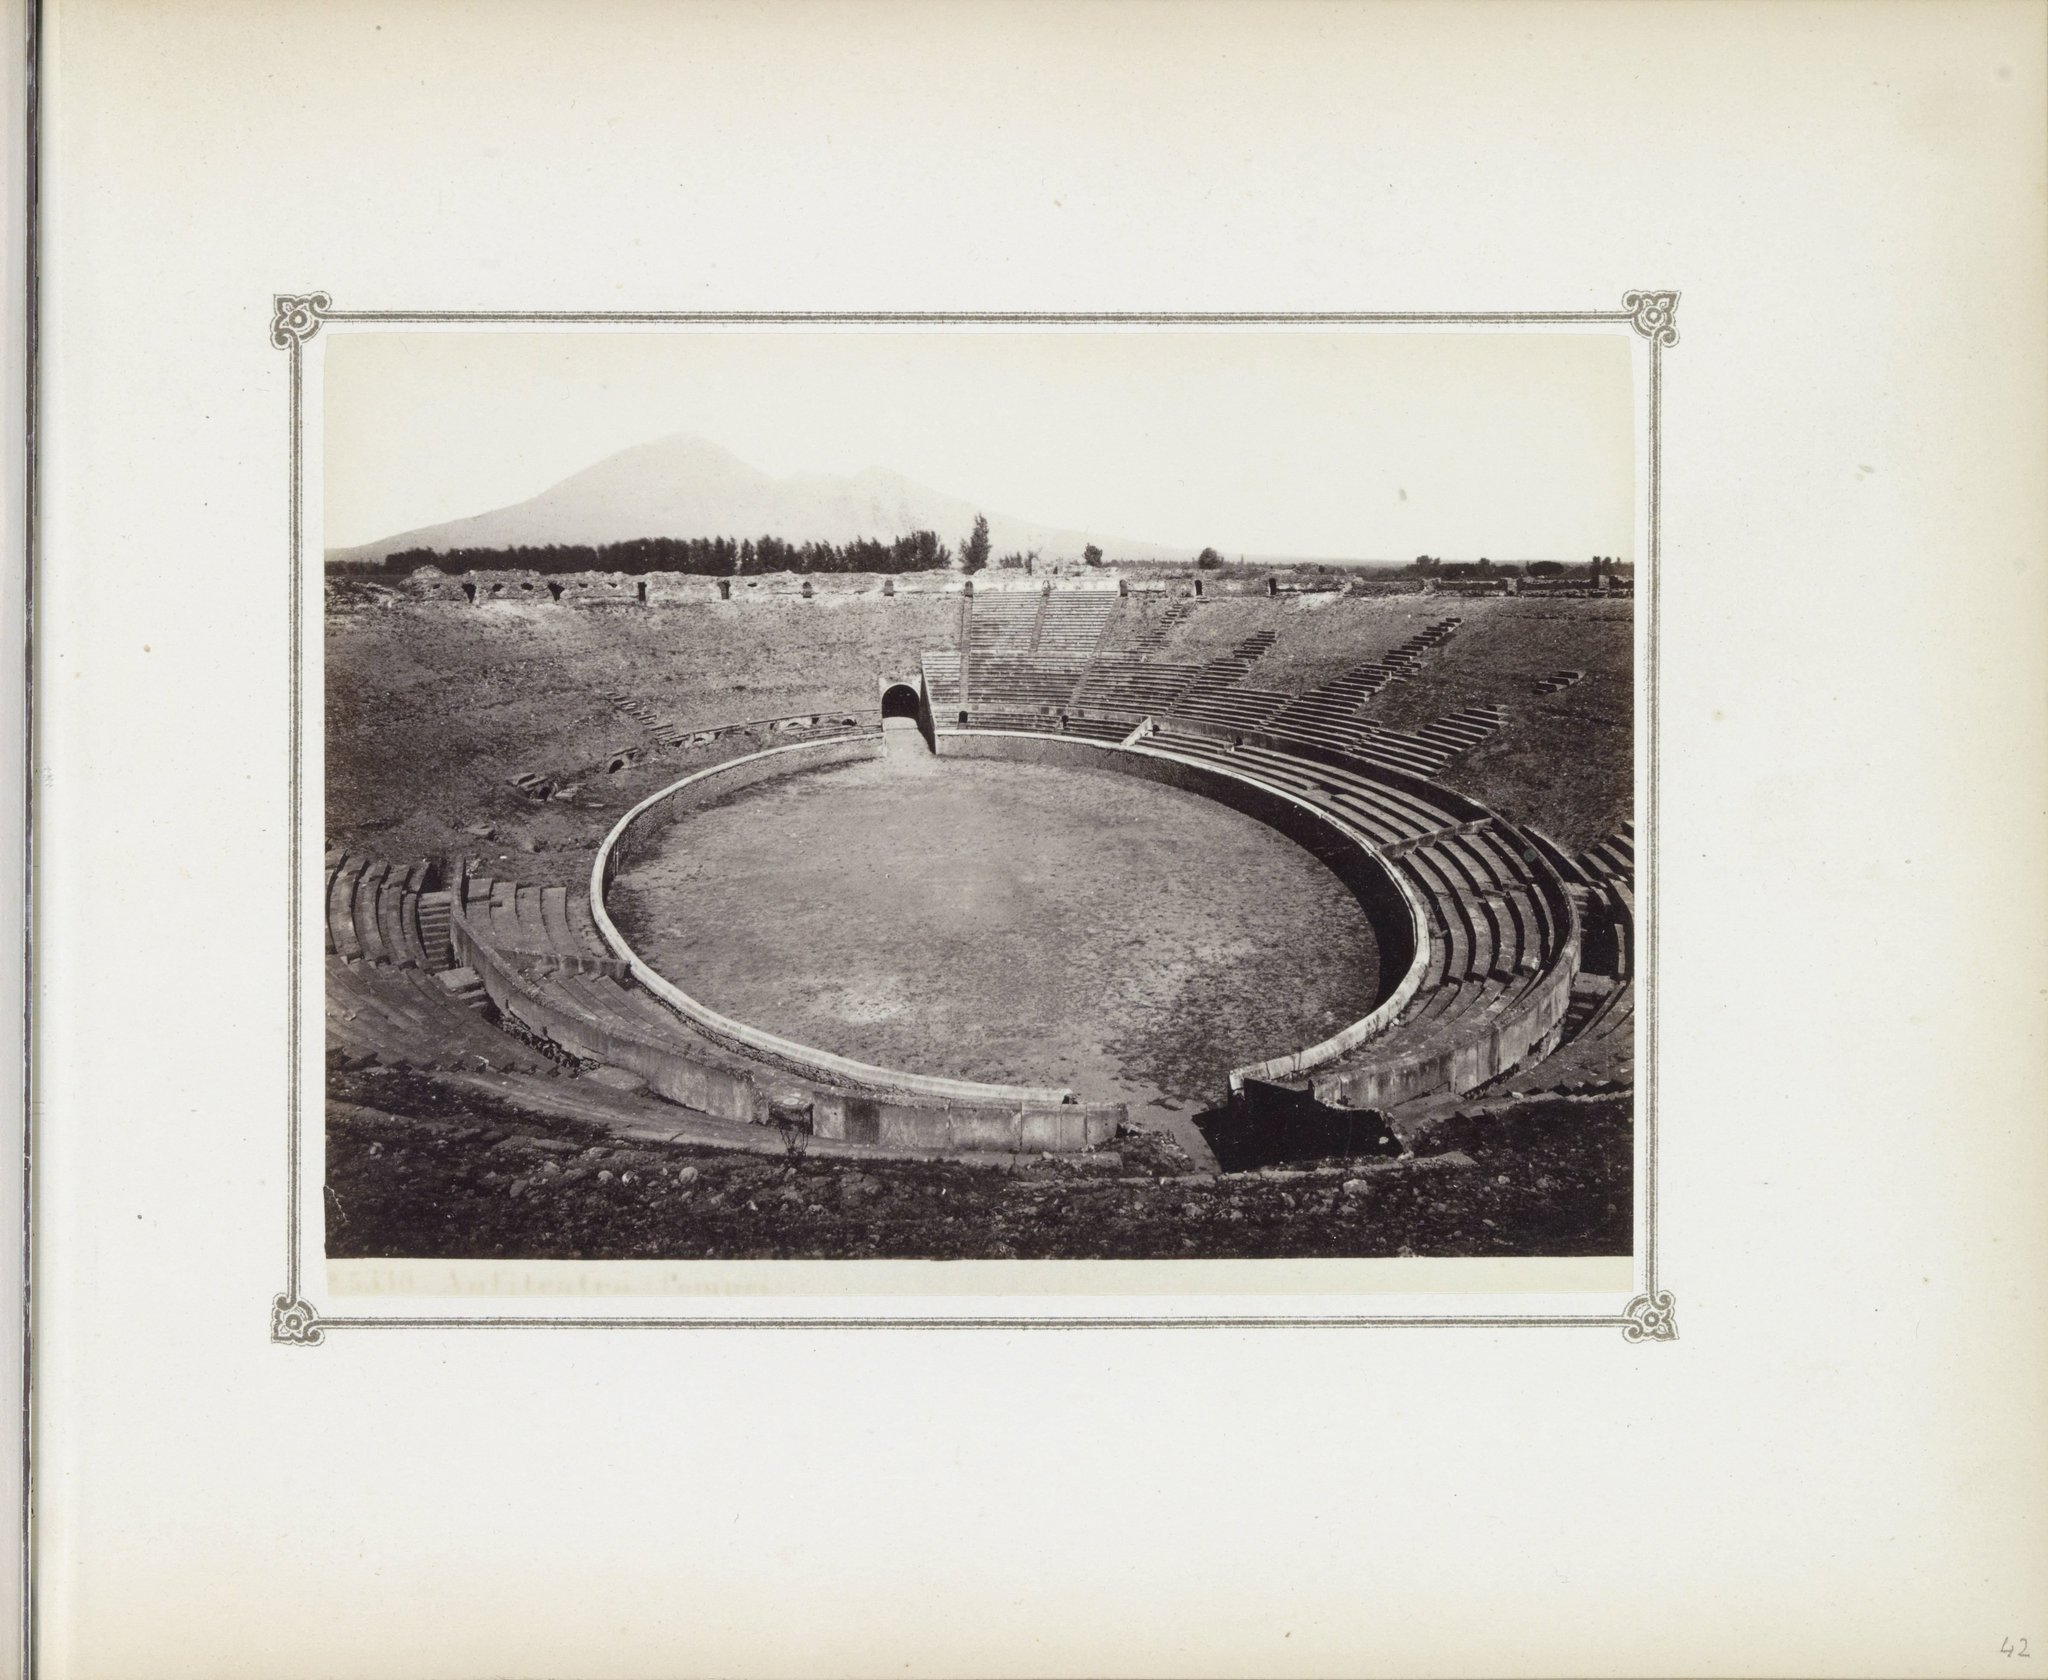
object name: photograph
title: Interieur van het amfitheater in Pompeï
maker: giorgio sommer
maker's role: fotograaf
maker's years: 1834-1914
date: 1860-1900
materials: paper, photographic support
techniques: albumen print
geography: pompeii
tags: theatre (building) - aa - open-air performances, excavation ~ archaeology, pompeii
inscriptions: number: ‘53[...]’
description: Onderdeel van Fotoalbum met opnames van opgravingen in Pompeï door Giorgio Sommer.